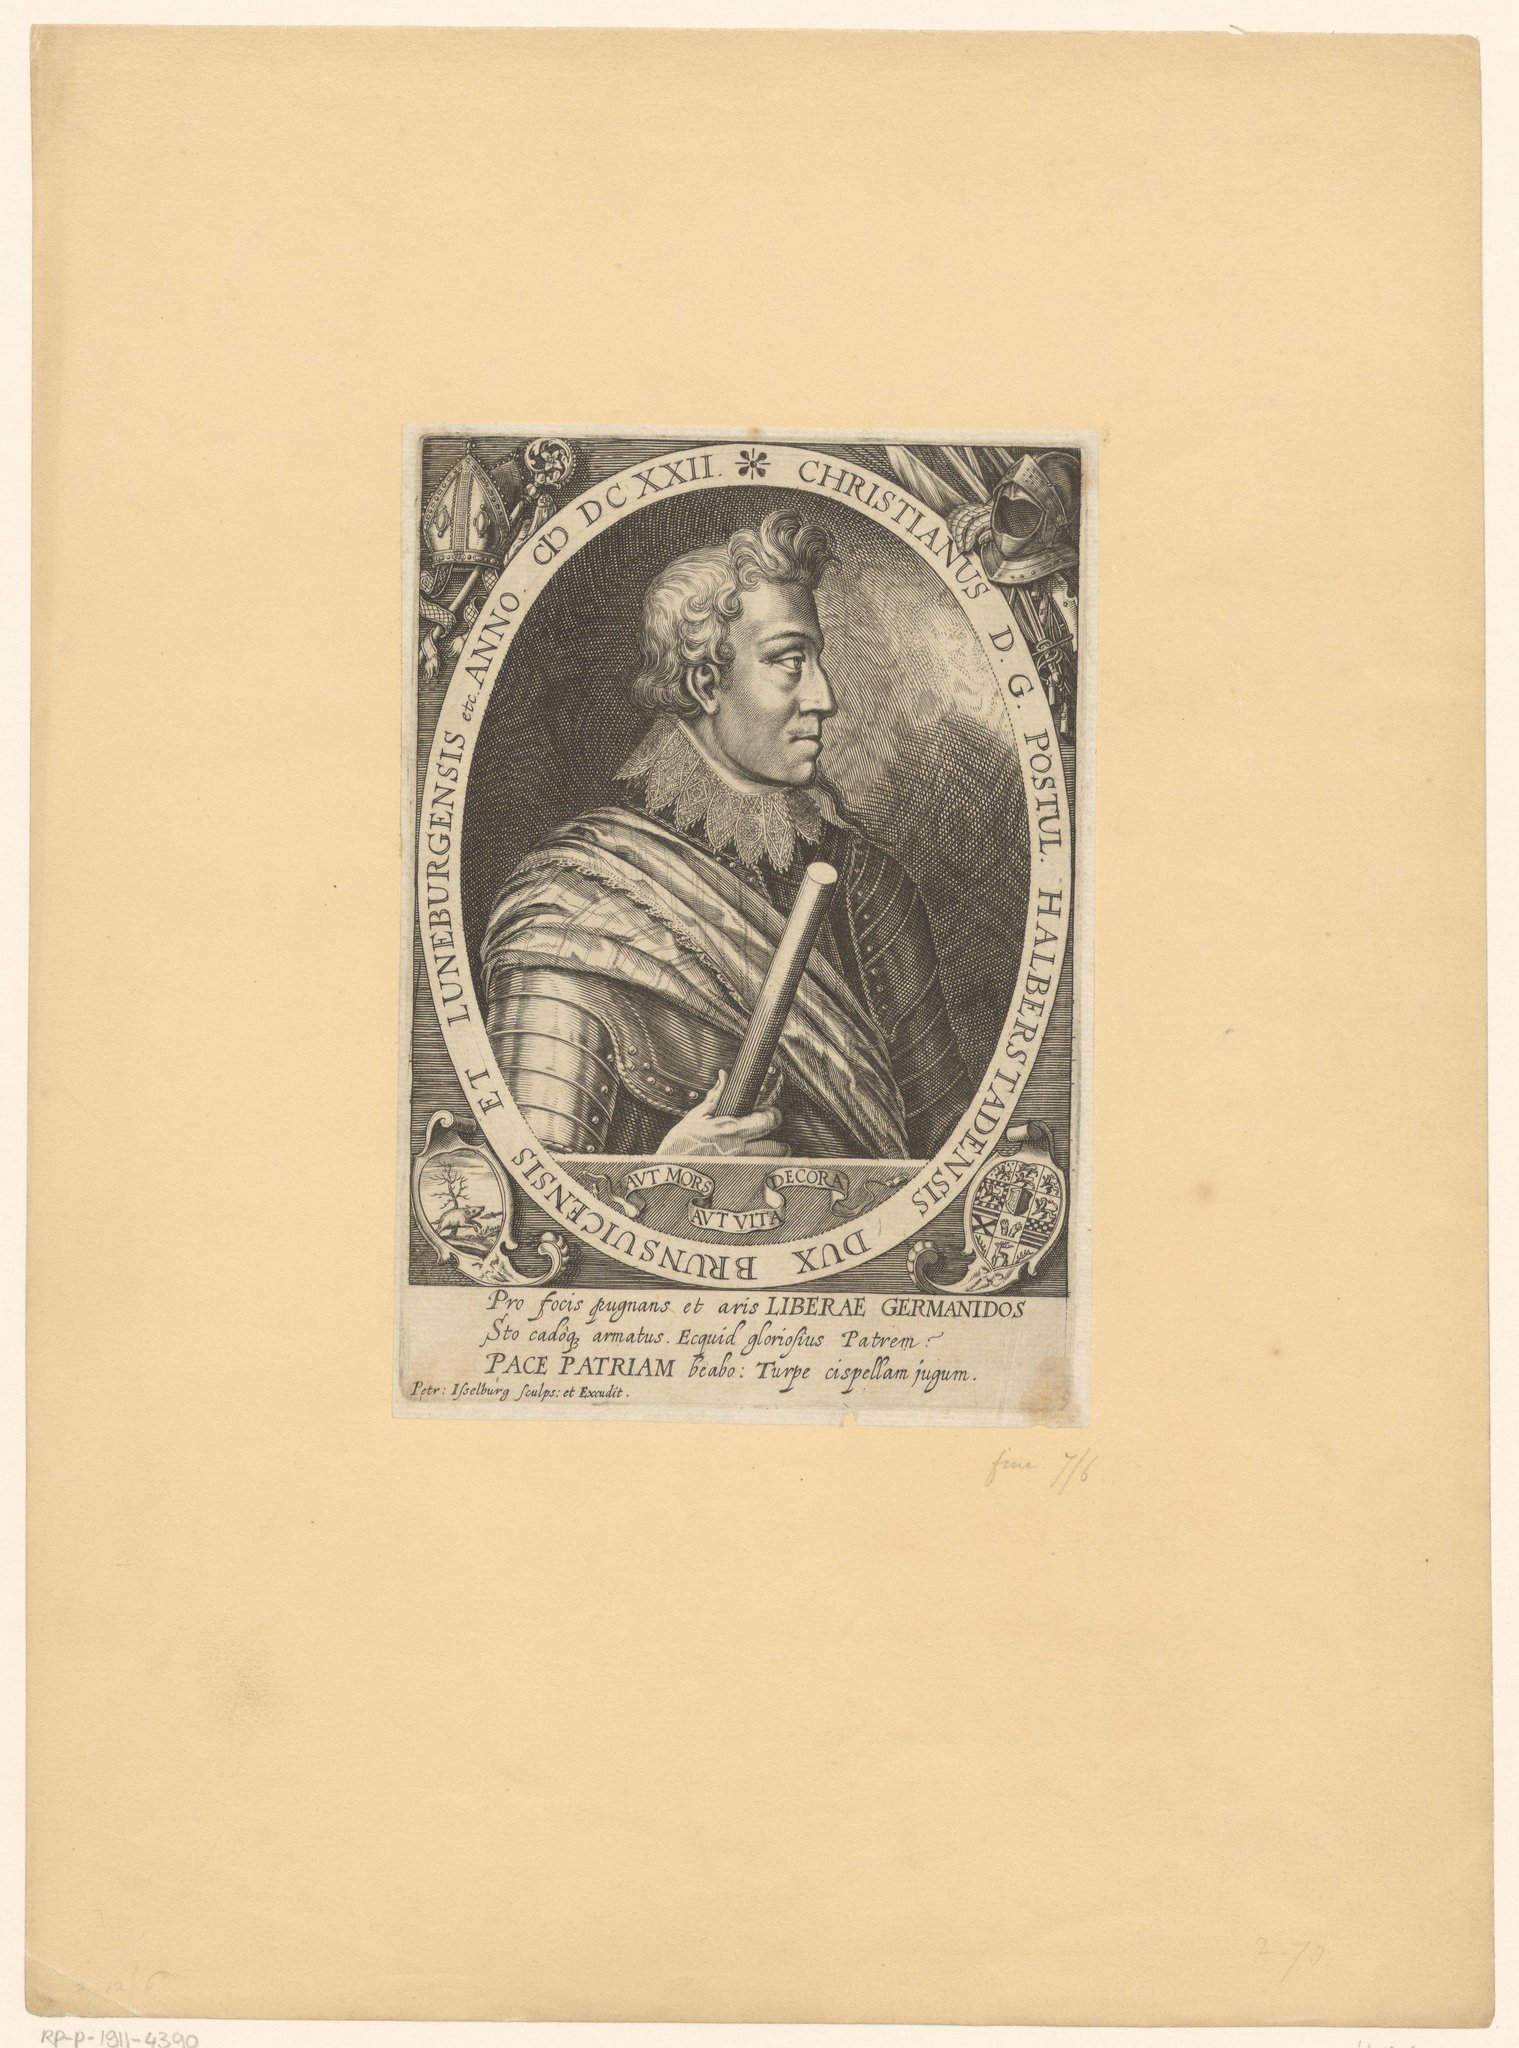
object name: print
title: Portret van Christian von Braunschweig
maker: peter isselburg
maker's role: print maker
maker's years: 1568-1630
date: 1578-1630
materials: paper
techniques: engraving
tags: historical persons, ruler, sovereign, baton of general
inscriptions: collector's mark: Lugt 2228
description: Portret in medaillon en profil naar links. Tekst in het Latijn in de omlijsting en in de marge.